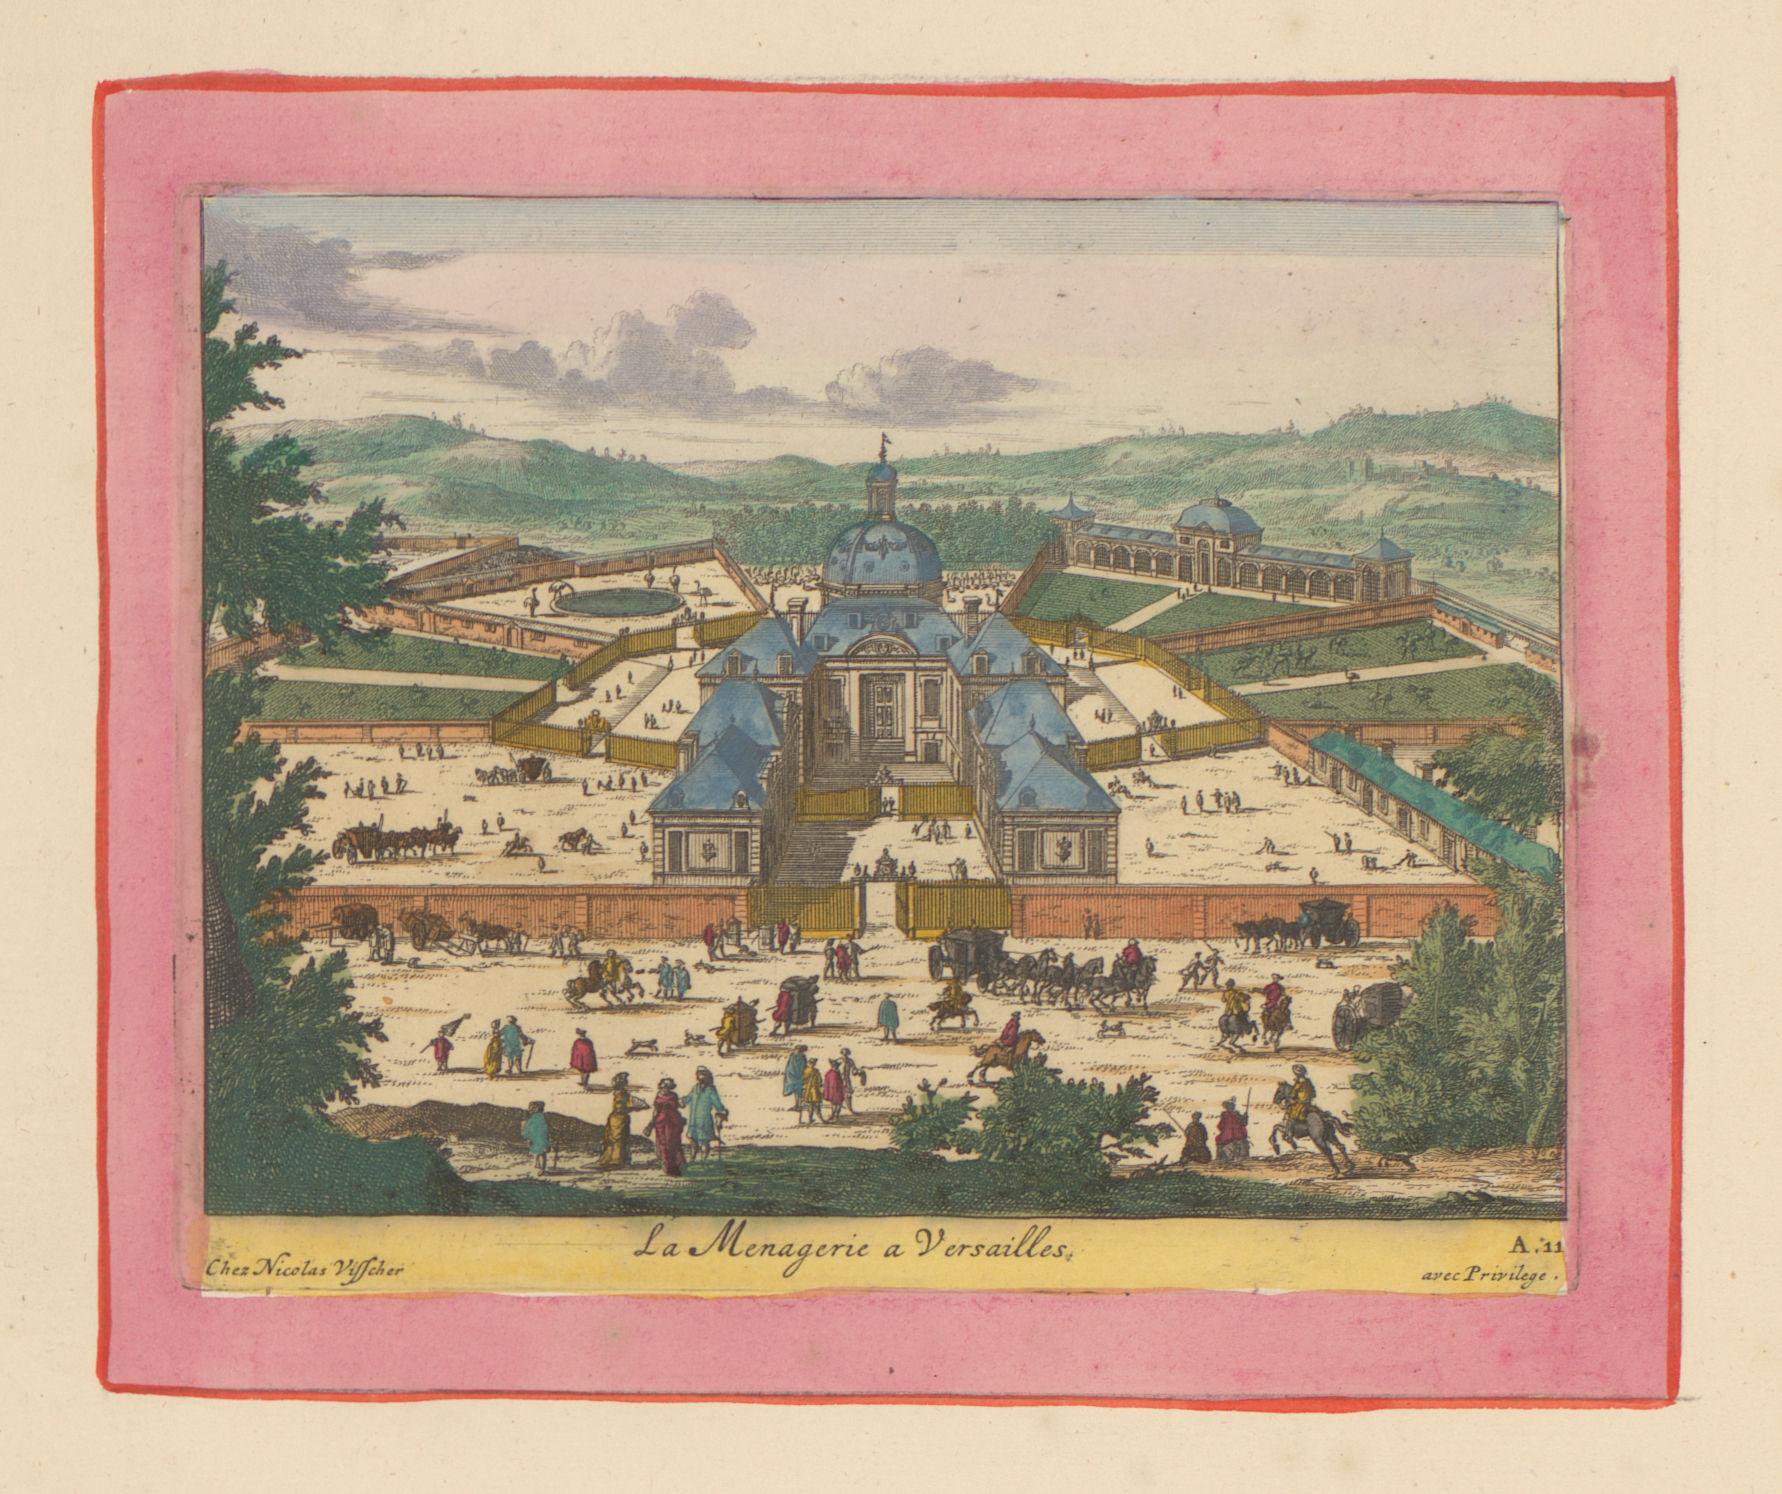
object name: print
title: Veues de Versailles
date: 1686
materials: paper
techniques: etching, hand coloring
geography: amsterdam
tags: french or architectonic garden; formal garden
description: De prent maakt deel uit van een serie bestaande uit 87 genummerde prenten (volgens Hollstein). De serie is opgedeeld in de delen A t/m F.